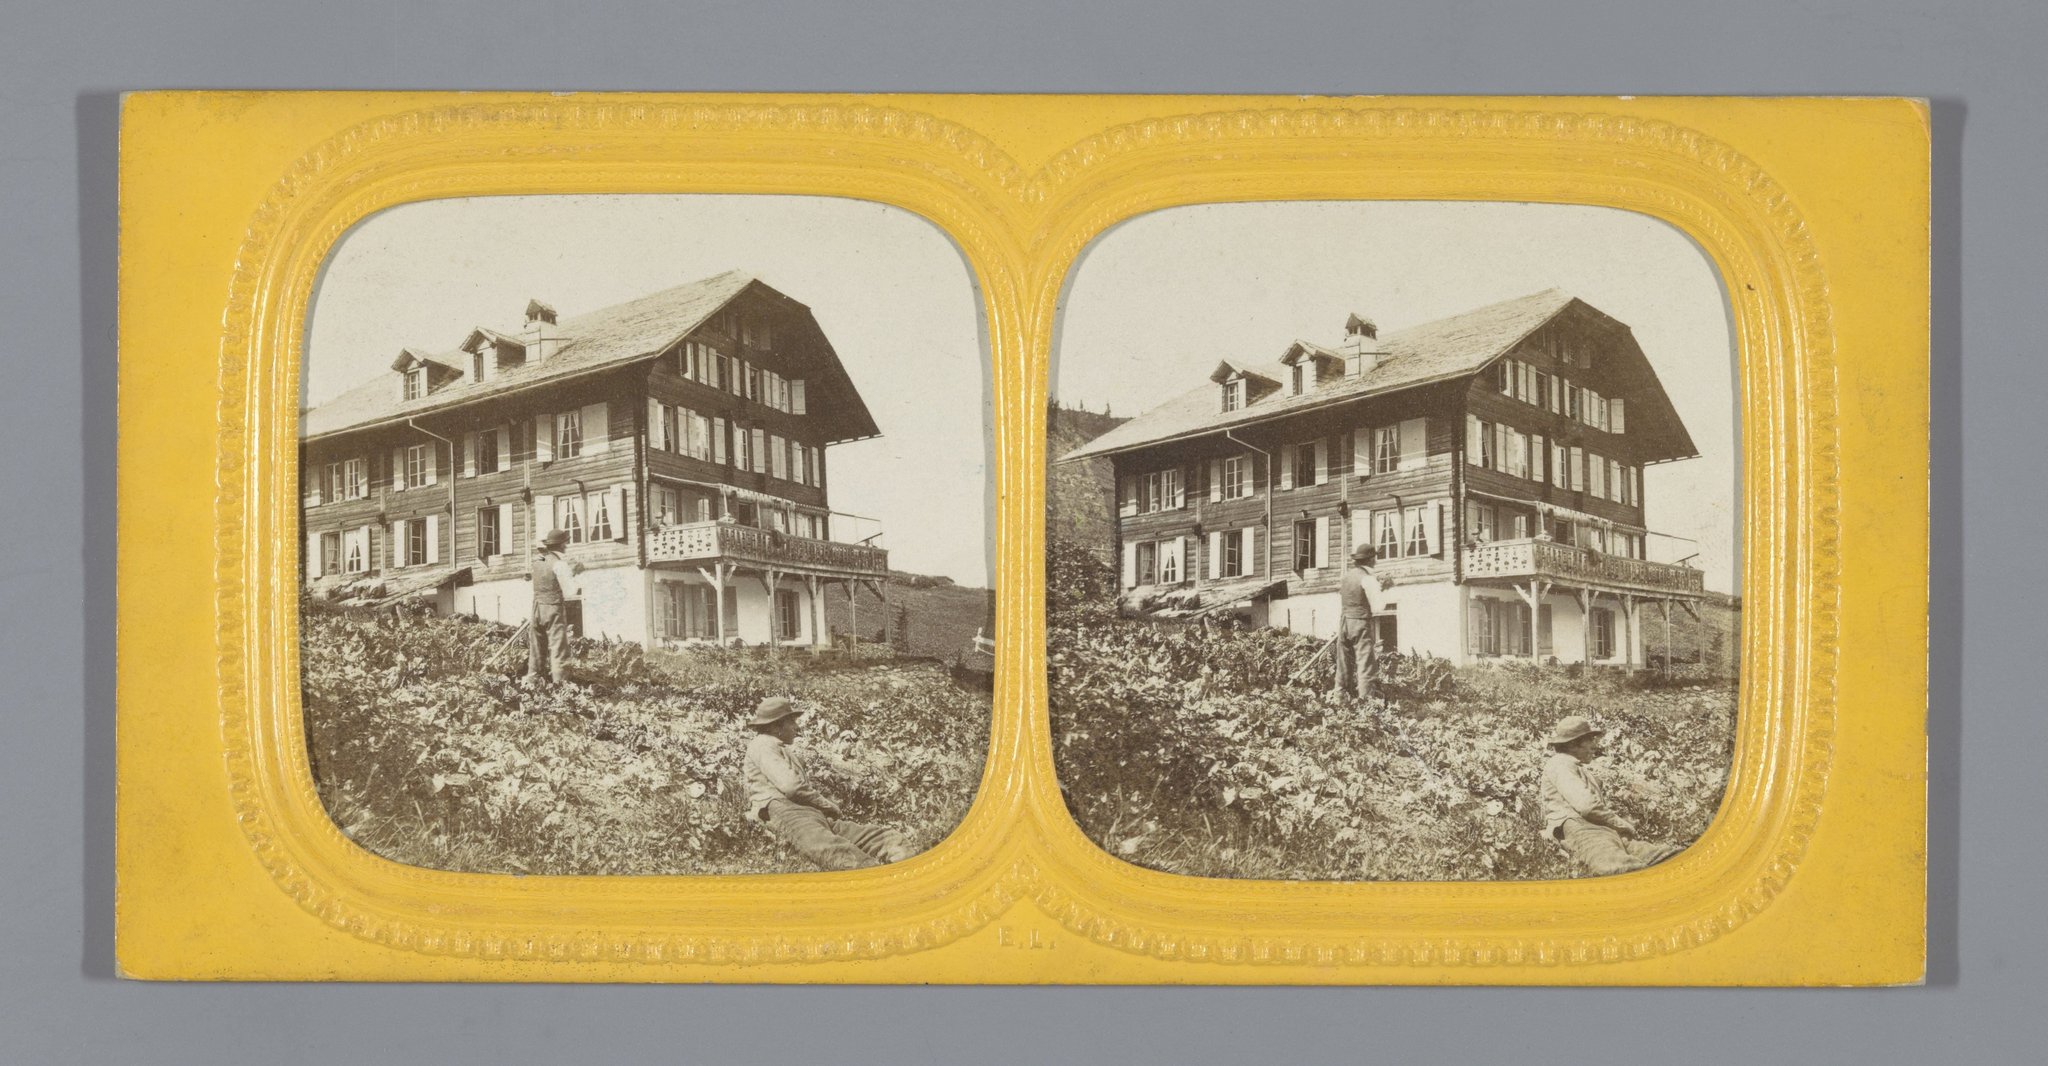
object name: tissue stereograph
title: Hotelgebouw in Mürren, Zwitserland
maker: Anonymous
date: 1855-1875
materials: cardboard, paper, photographic support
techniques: albumen print, hand coloring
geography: mürren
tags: exterior ~ representation of a building, landscapes (+ landscape with figures, staffage), hotel, hostelry, inn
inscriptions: monogram: ‘E.L.’, number: ‘140.’